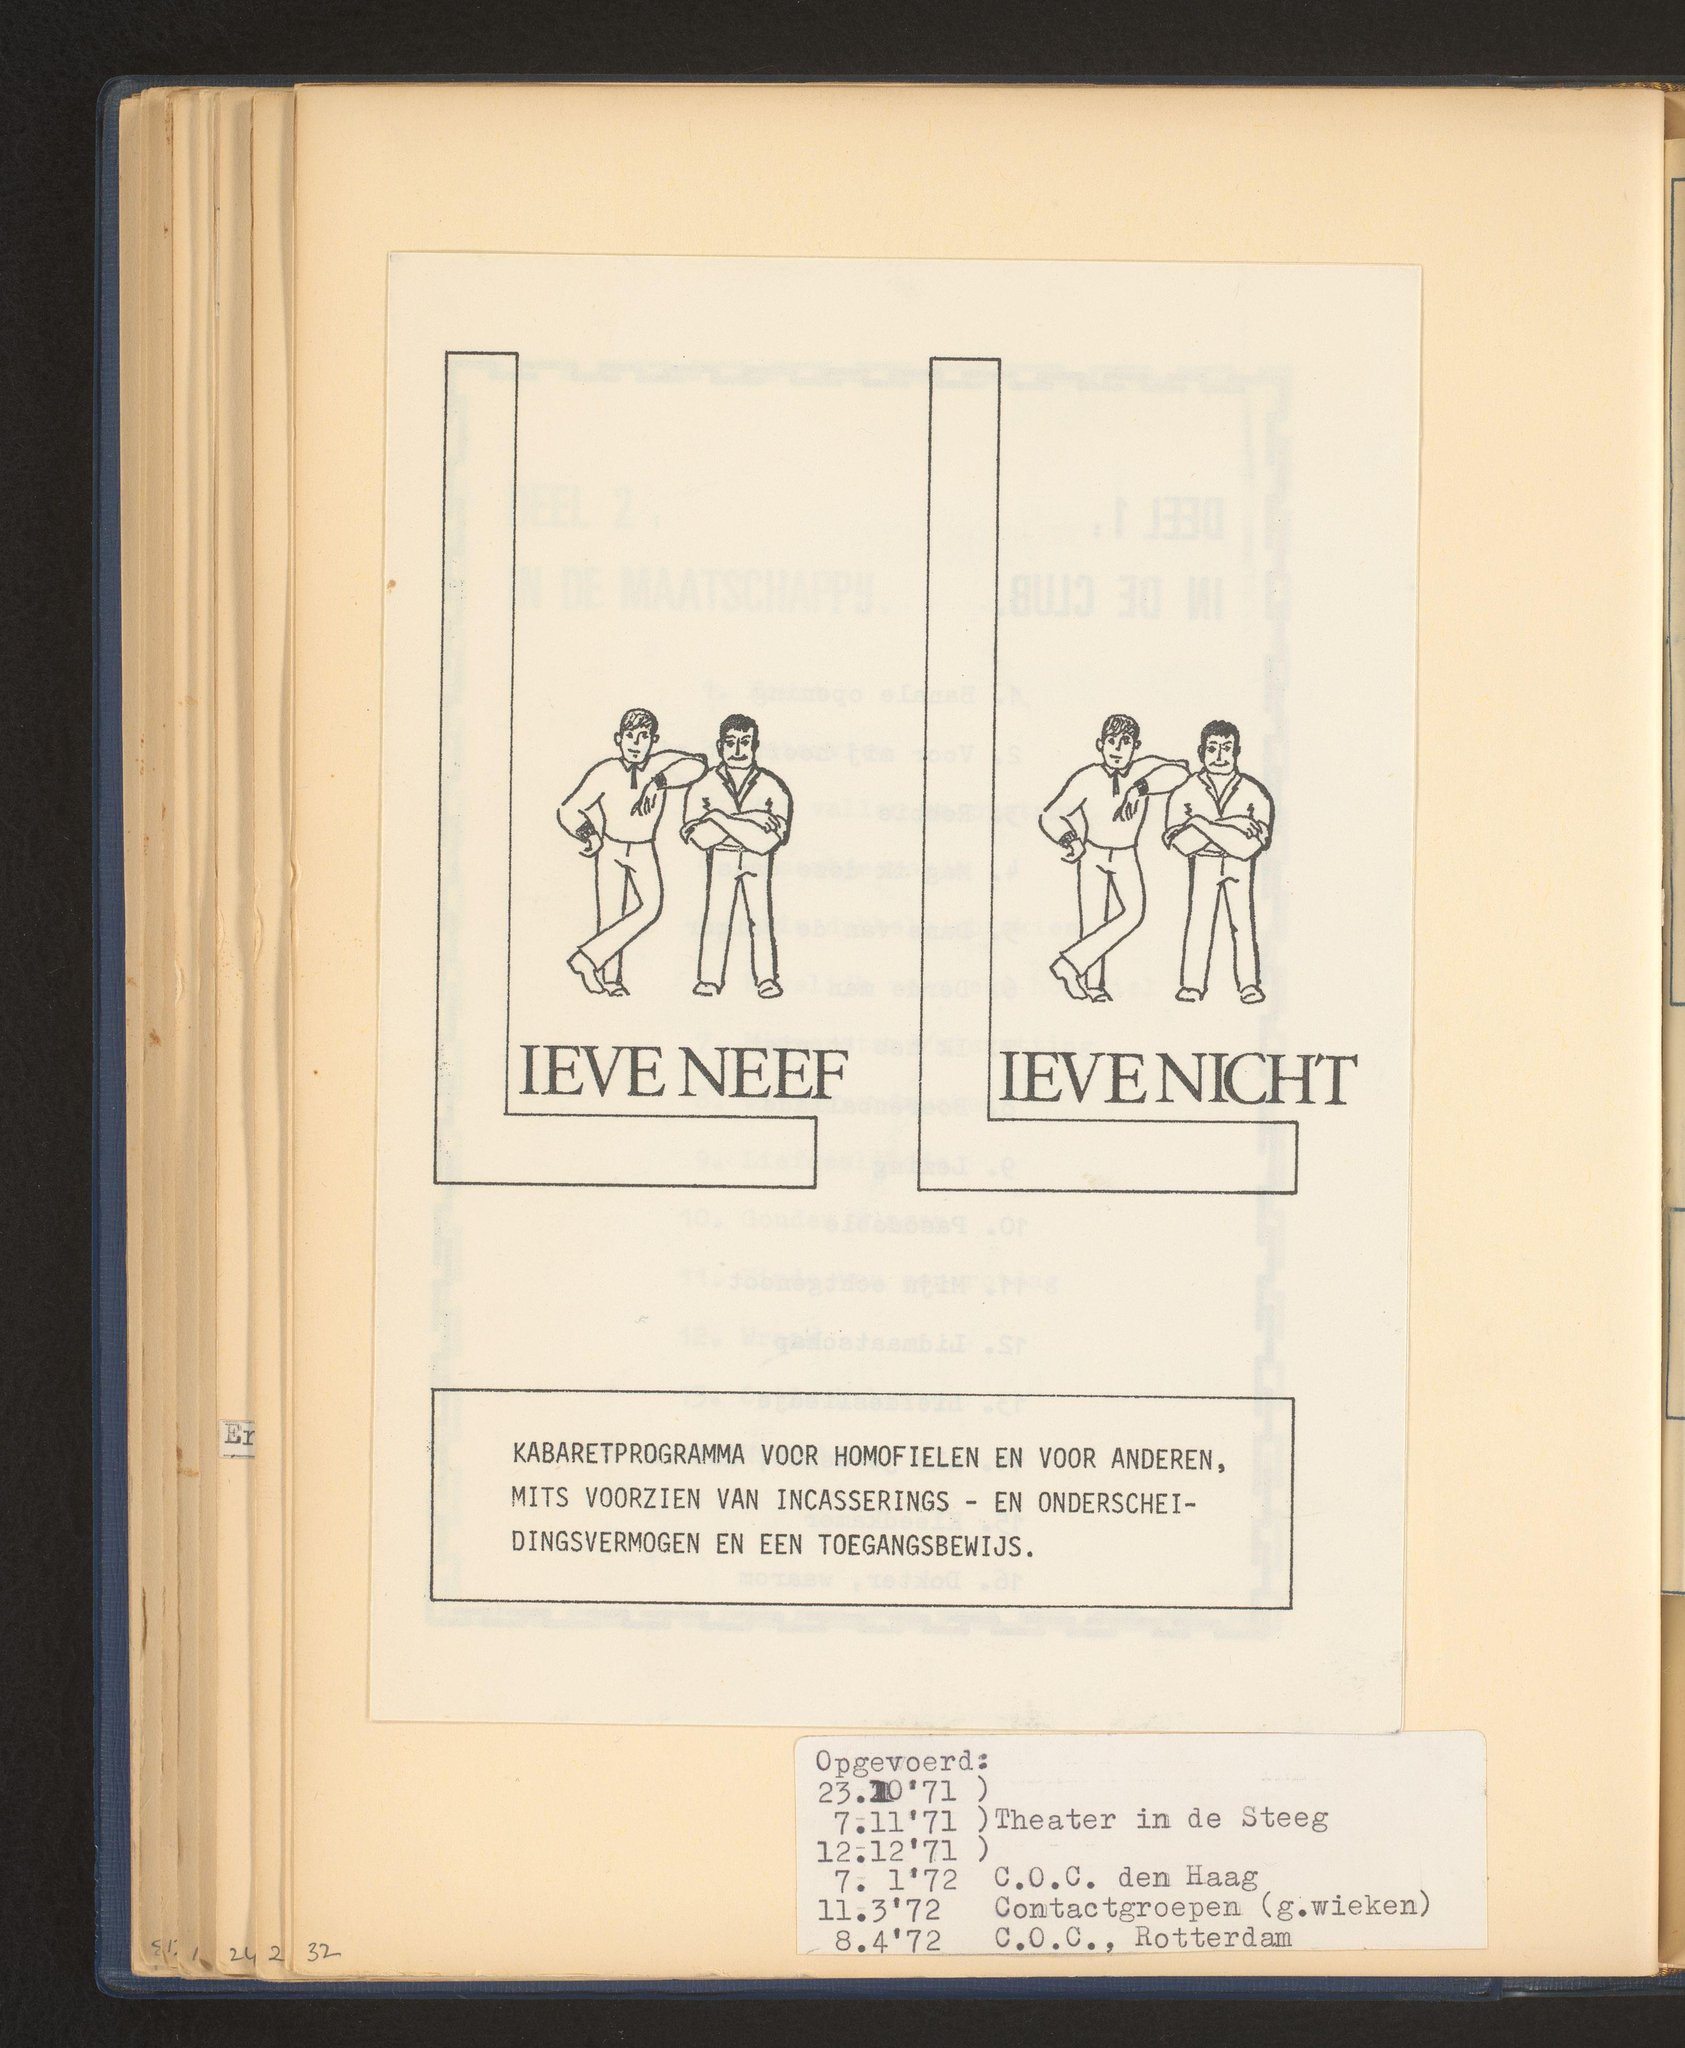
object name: programma, programmaboekje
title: Programma voor de cabaretvoorstelling 'Lieve Neef - Lieve Nicht' verzorgd door leden van het COC afdeling Den Haag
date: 1971-1972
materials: cardboard, paper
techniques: printed materials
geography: the hague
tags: the hague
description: Albumblad waarop zijn geplakt het programma voor de cabaretvoorstelling 'Lieve Neef - Lieve Nicht', verzorgd door leden van het COC afdeling Den Haag, en een overzichtje van de speeldata en plaatsen. Onderdeel van het fotoalbum van cabaretvoorstellingen COC 1968-1974, afdeling Den Haag.